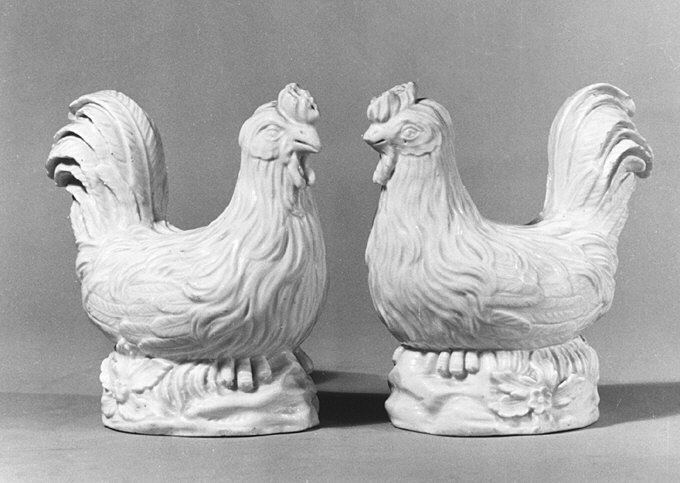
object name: figure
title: Cockerel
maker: saint-cloud factory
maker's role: factory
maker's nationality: french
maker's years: 1693-1766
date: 1740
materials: soft paste porcelain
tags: roosters